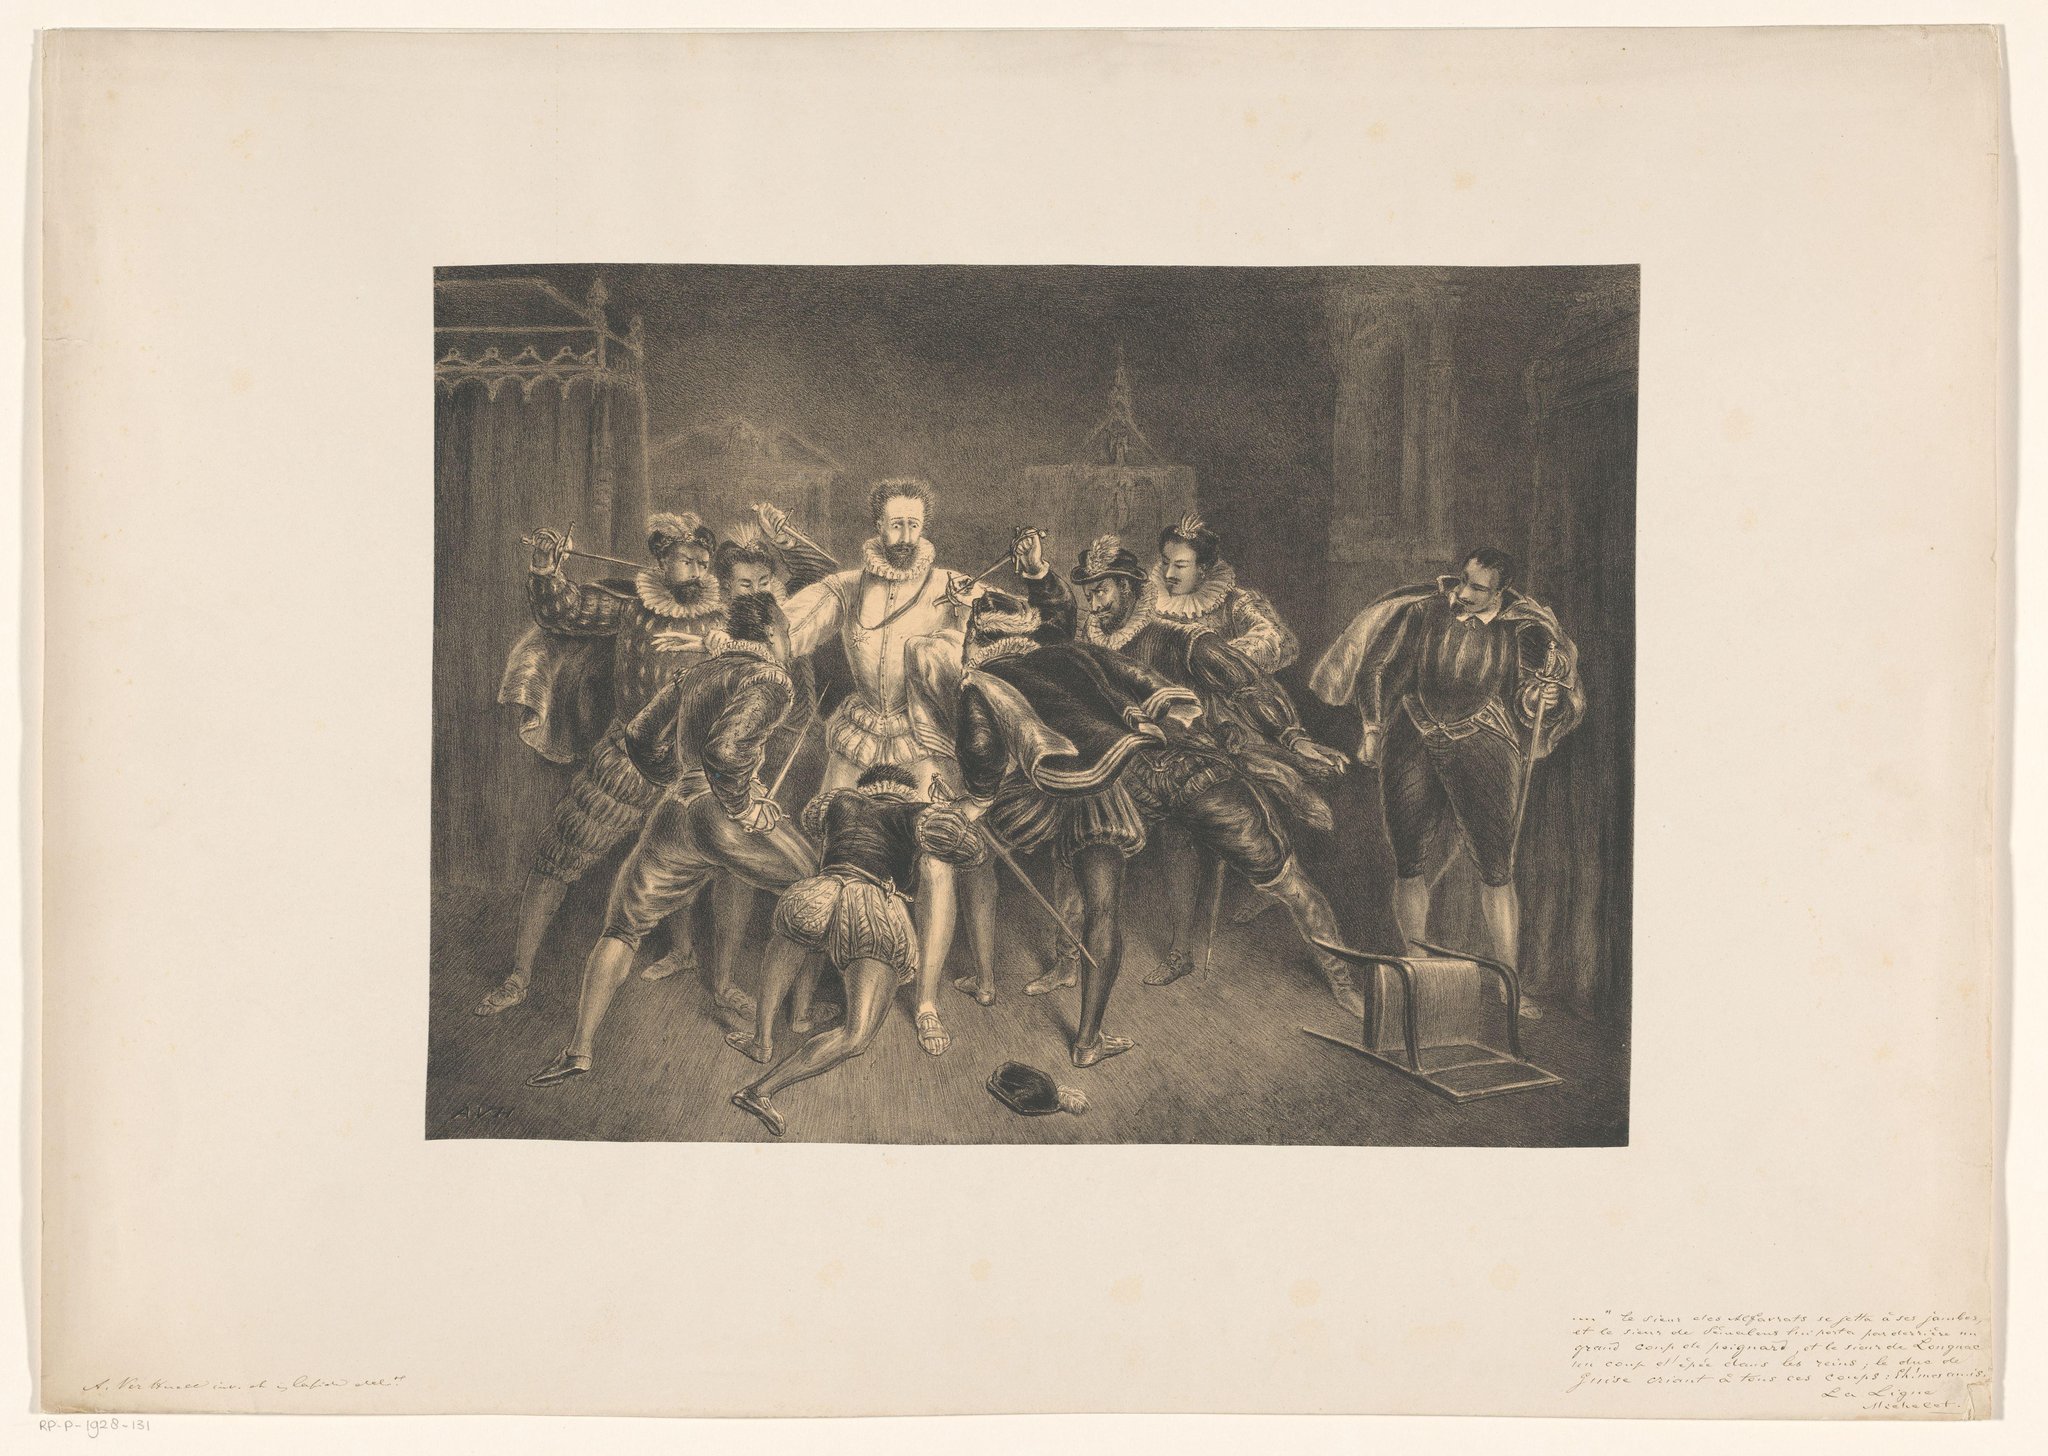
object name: print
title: Dood van Henrij de Guijse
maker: alexander ver huell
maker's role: draughtsman, print maker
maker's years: 1822-1897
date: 1866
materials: paper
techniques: tone lithography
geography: netherlands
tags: murder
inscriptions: inscription: ‘.... "le sieur des (...) La Ligne Michelot.’, collector's mark: Lugt 2228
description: Voorstelling van de moord op Hendrik I van Guise (1550-1588). Diverse mannen steken in op de hertog de Guise in het kasteel van Blois.